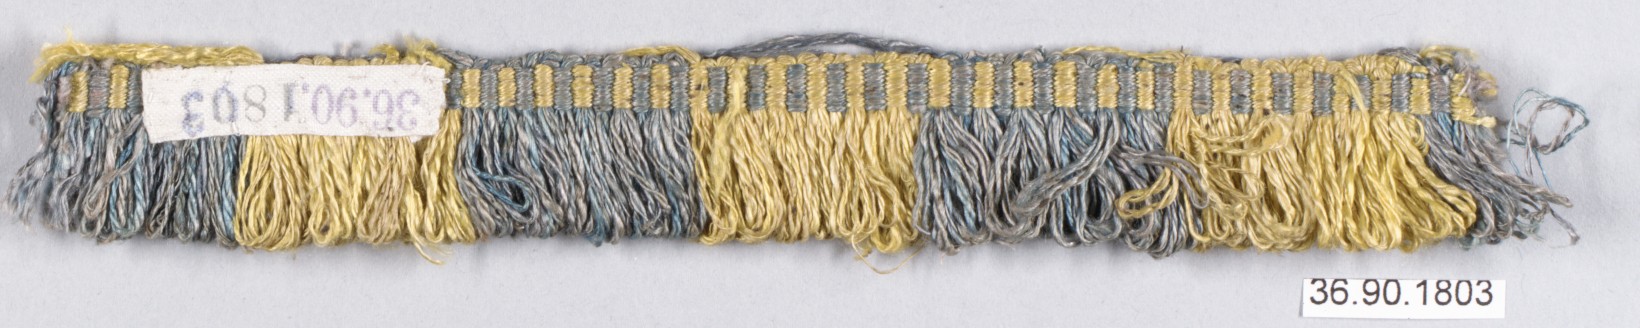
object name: fringe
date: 1701-1733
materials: silk